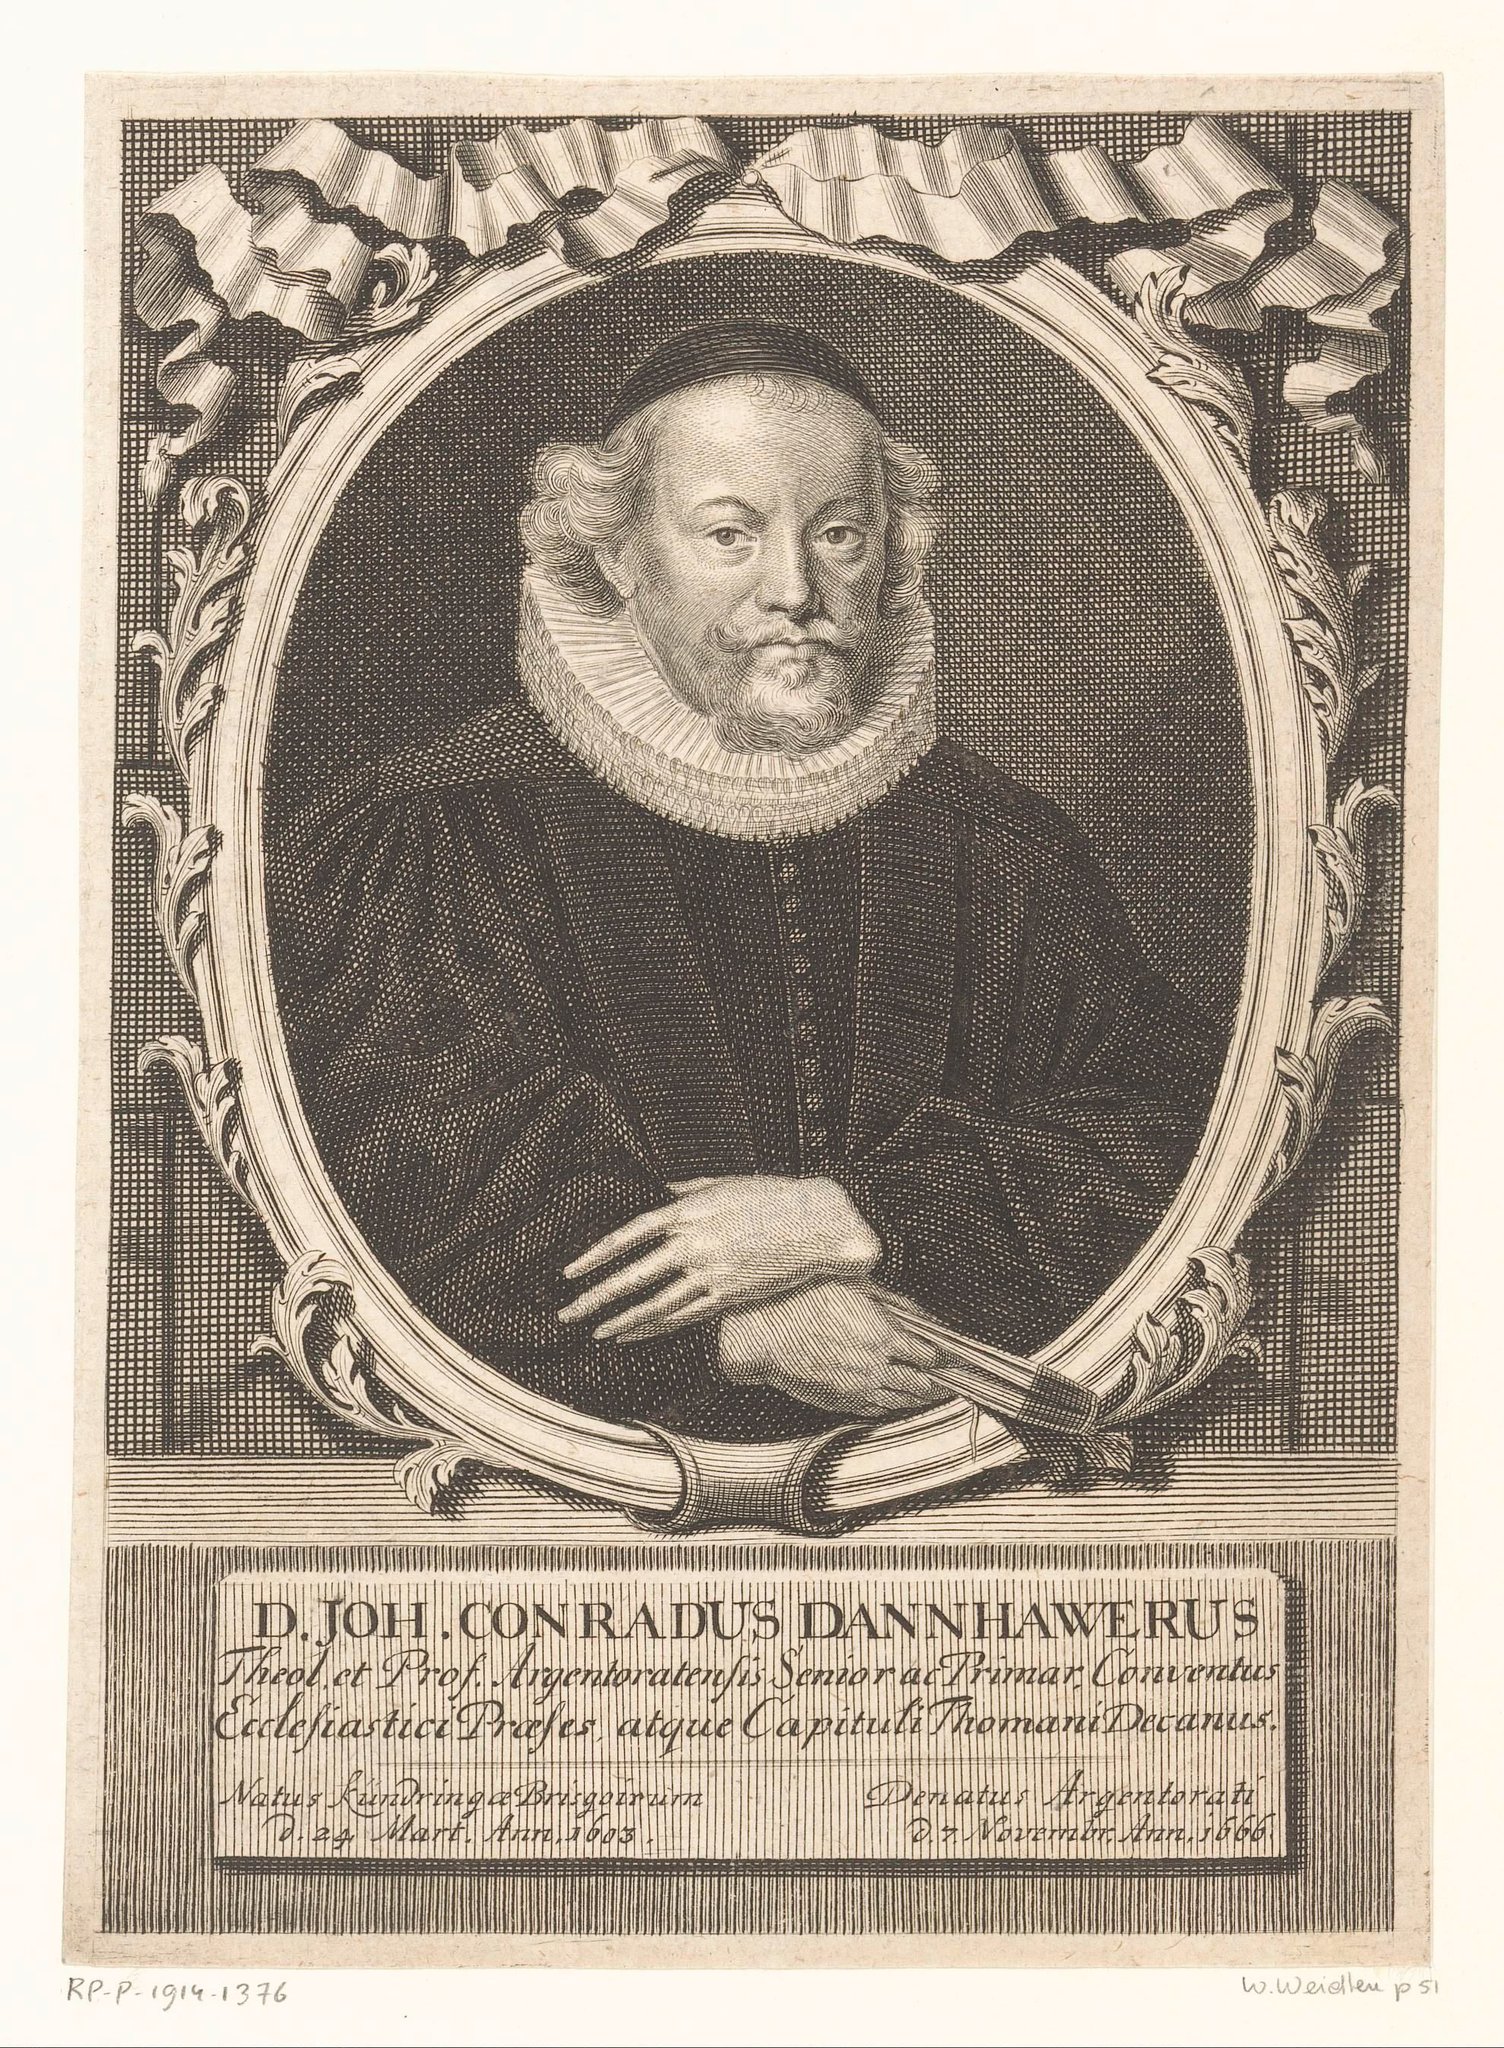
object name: print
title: Portret van Johann Conrad Dannhauer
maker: martin bernigeroth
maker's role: print maker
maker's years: 1670-1733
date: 1680-1733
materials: paper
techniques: engraving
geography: leipzig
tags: johann conrad dannhauer, historical persons, book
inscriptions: collector's mark: Lugt 2228